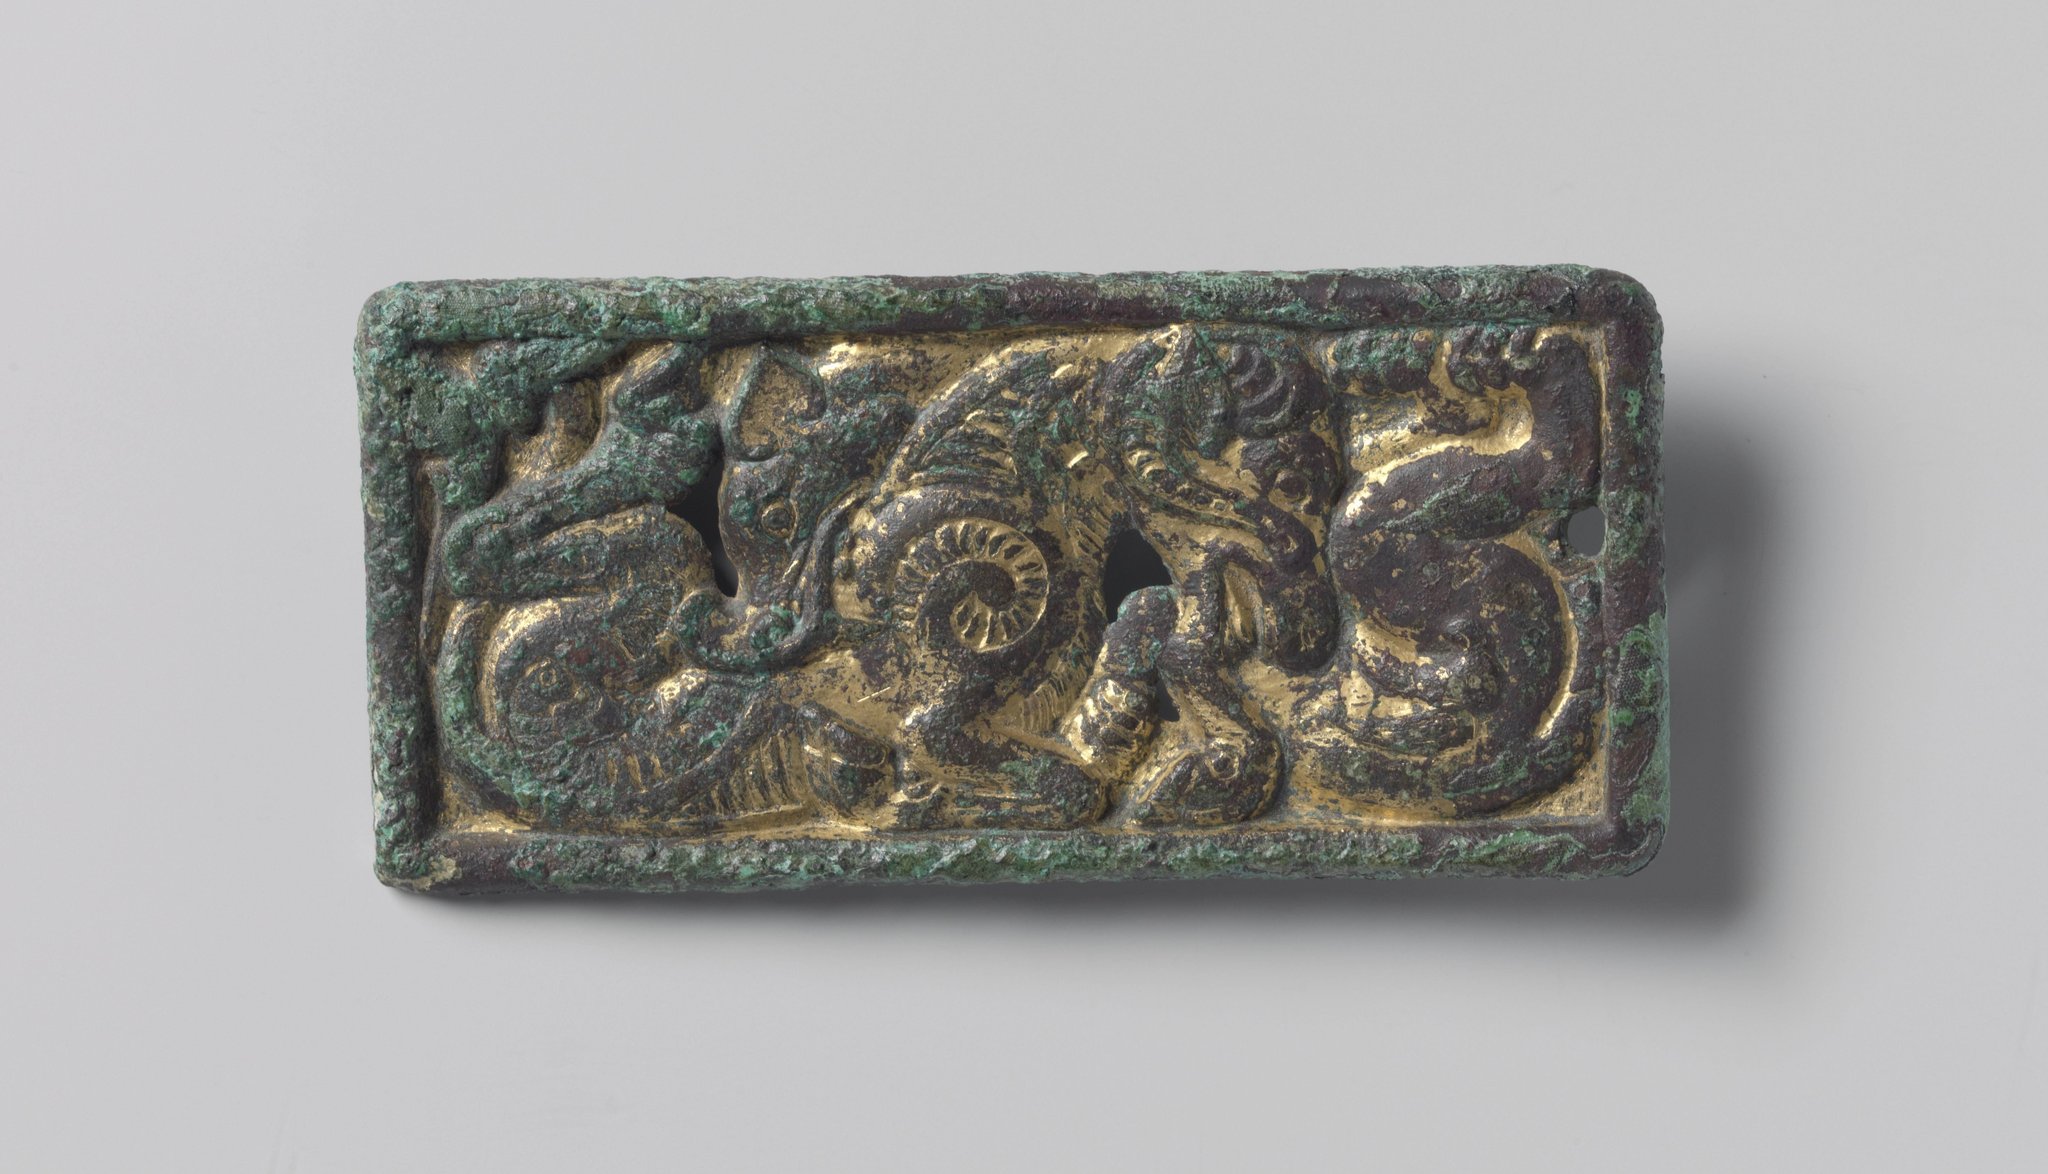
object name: schoolplak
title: Ordos plaque met roofdieren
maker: Anonymous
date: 206-220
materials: bronze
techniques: gilding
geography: ordos plateau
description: Opengewerkte plak met een voorstelling van twee elkaar omstrengelende roofdieren.